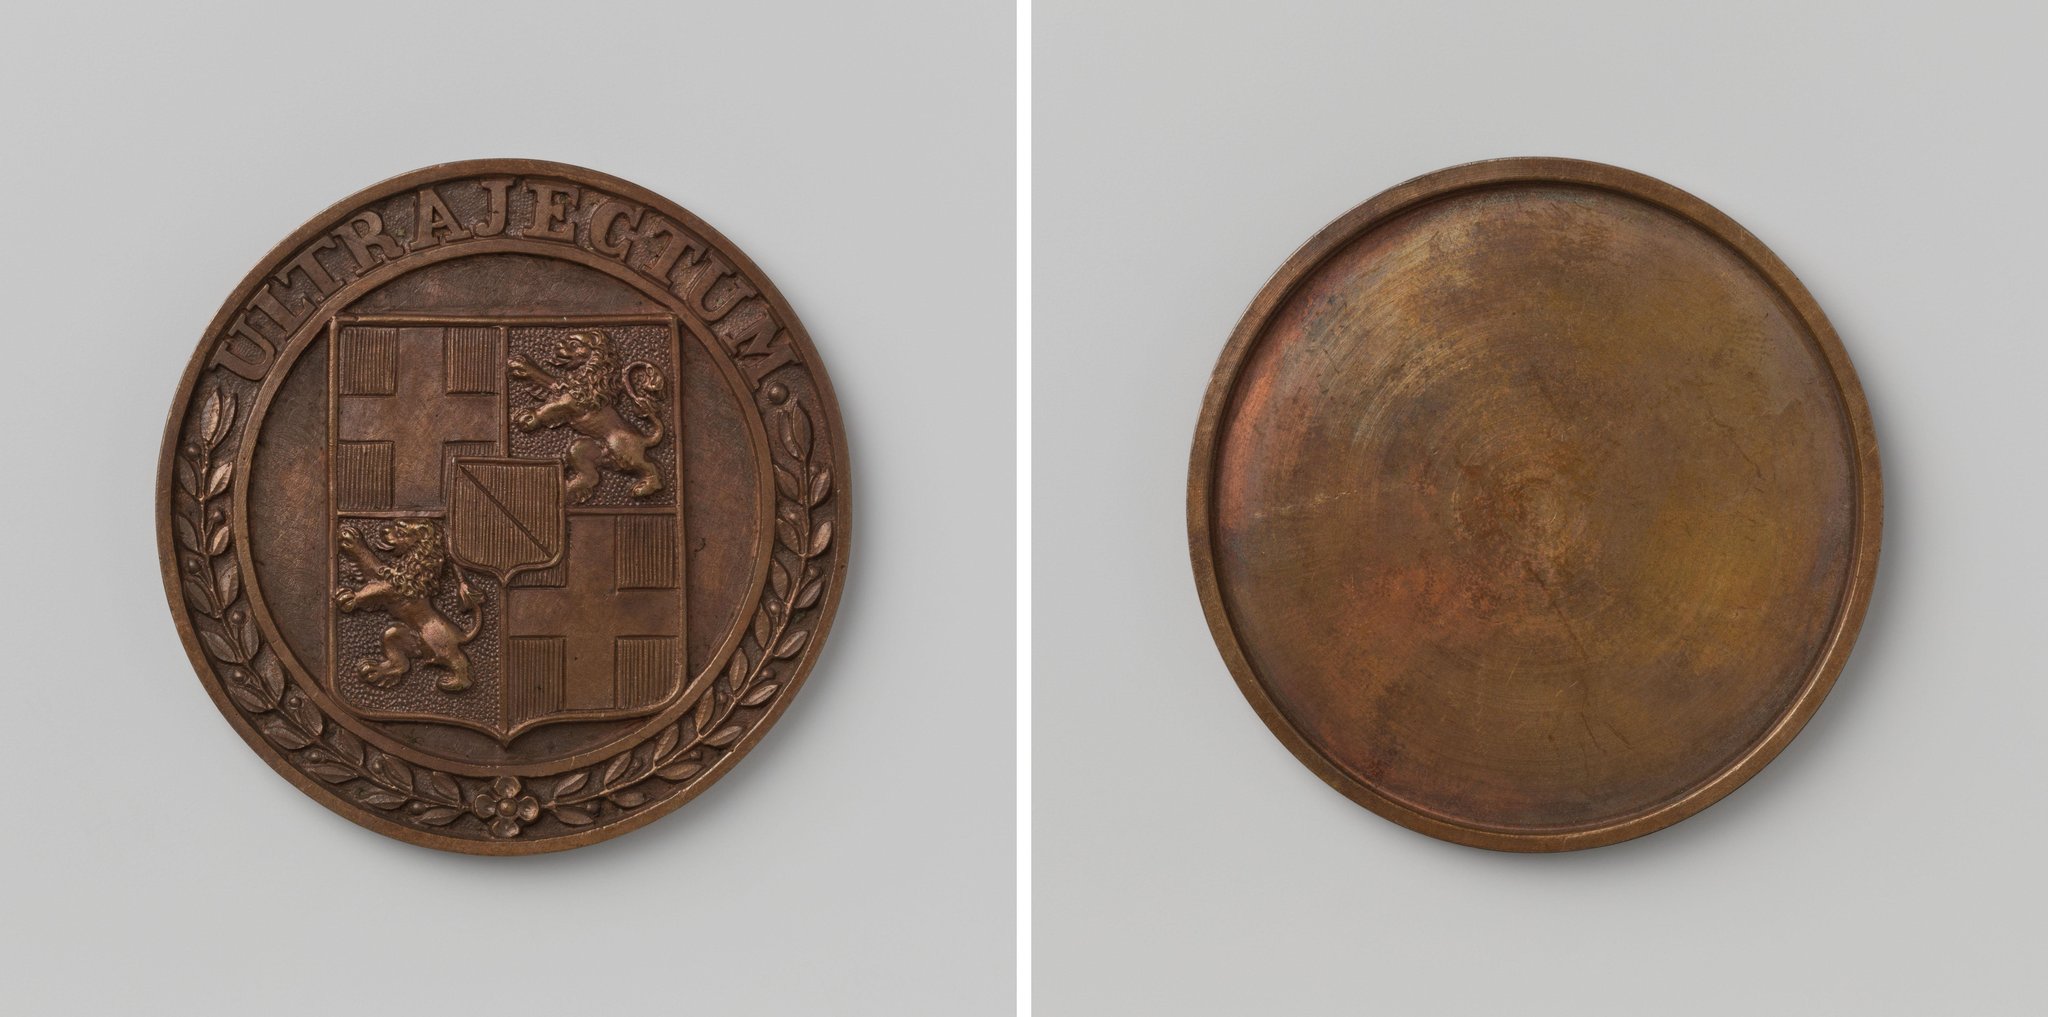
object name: medal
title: Utrecht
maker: Anonymous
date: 1815-1830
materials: bronze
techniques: striking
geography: netherlands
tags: eemland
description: Eenzijdige bronzen penning. Voorzijde: wapenschild binnen bladerkrans en omschrift. Keerzijde: blanco